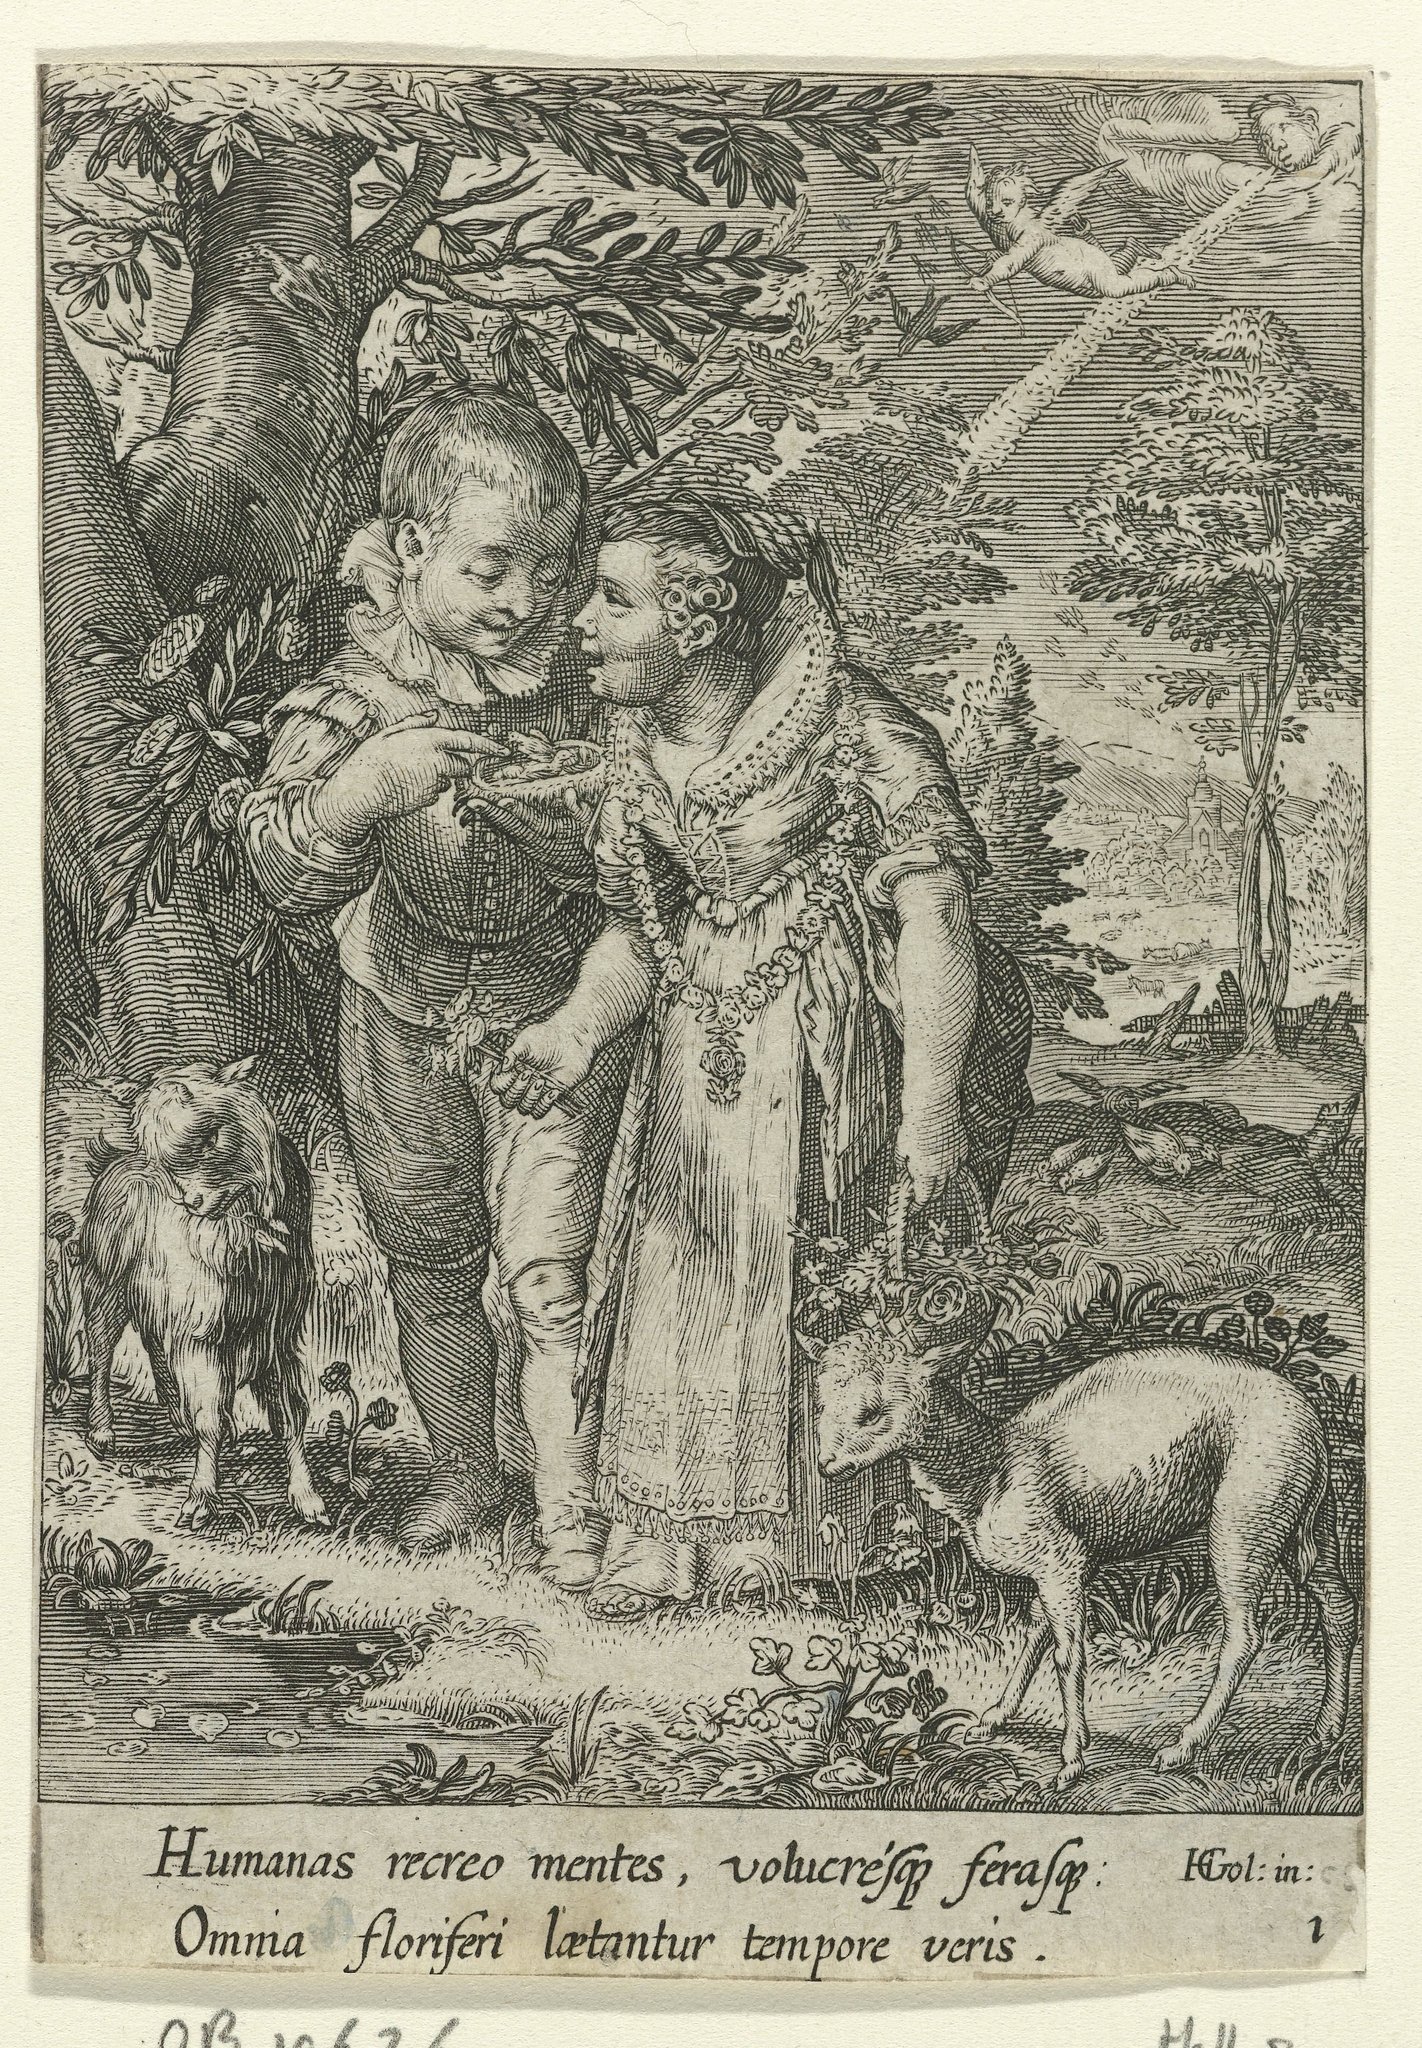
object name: print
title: De Lente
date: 1601-1651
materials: paper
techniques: engraving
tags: child robbing bird's nests (+ variant), spring, 'ver'; 'primavera' (ripa), spring ~ human activities (the four seasons of the year)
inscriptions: collector's mark: Lugt 2228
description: Een jongen en een meisje in een landschap. De jongen toont het meisje, met bloemenmandje in de hand, een vogelnest. Rechtsboven richt cupido zijn pijl op hen.